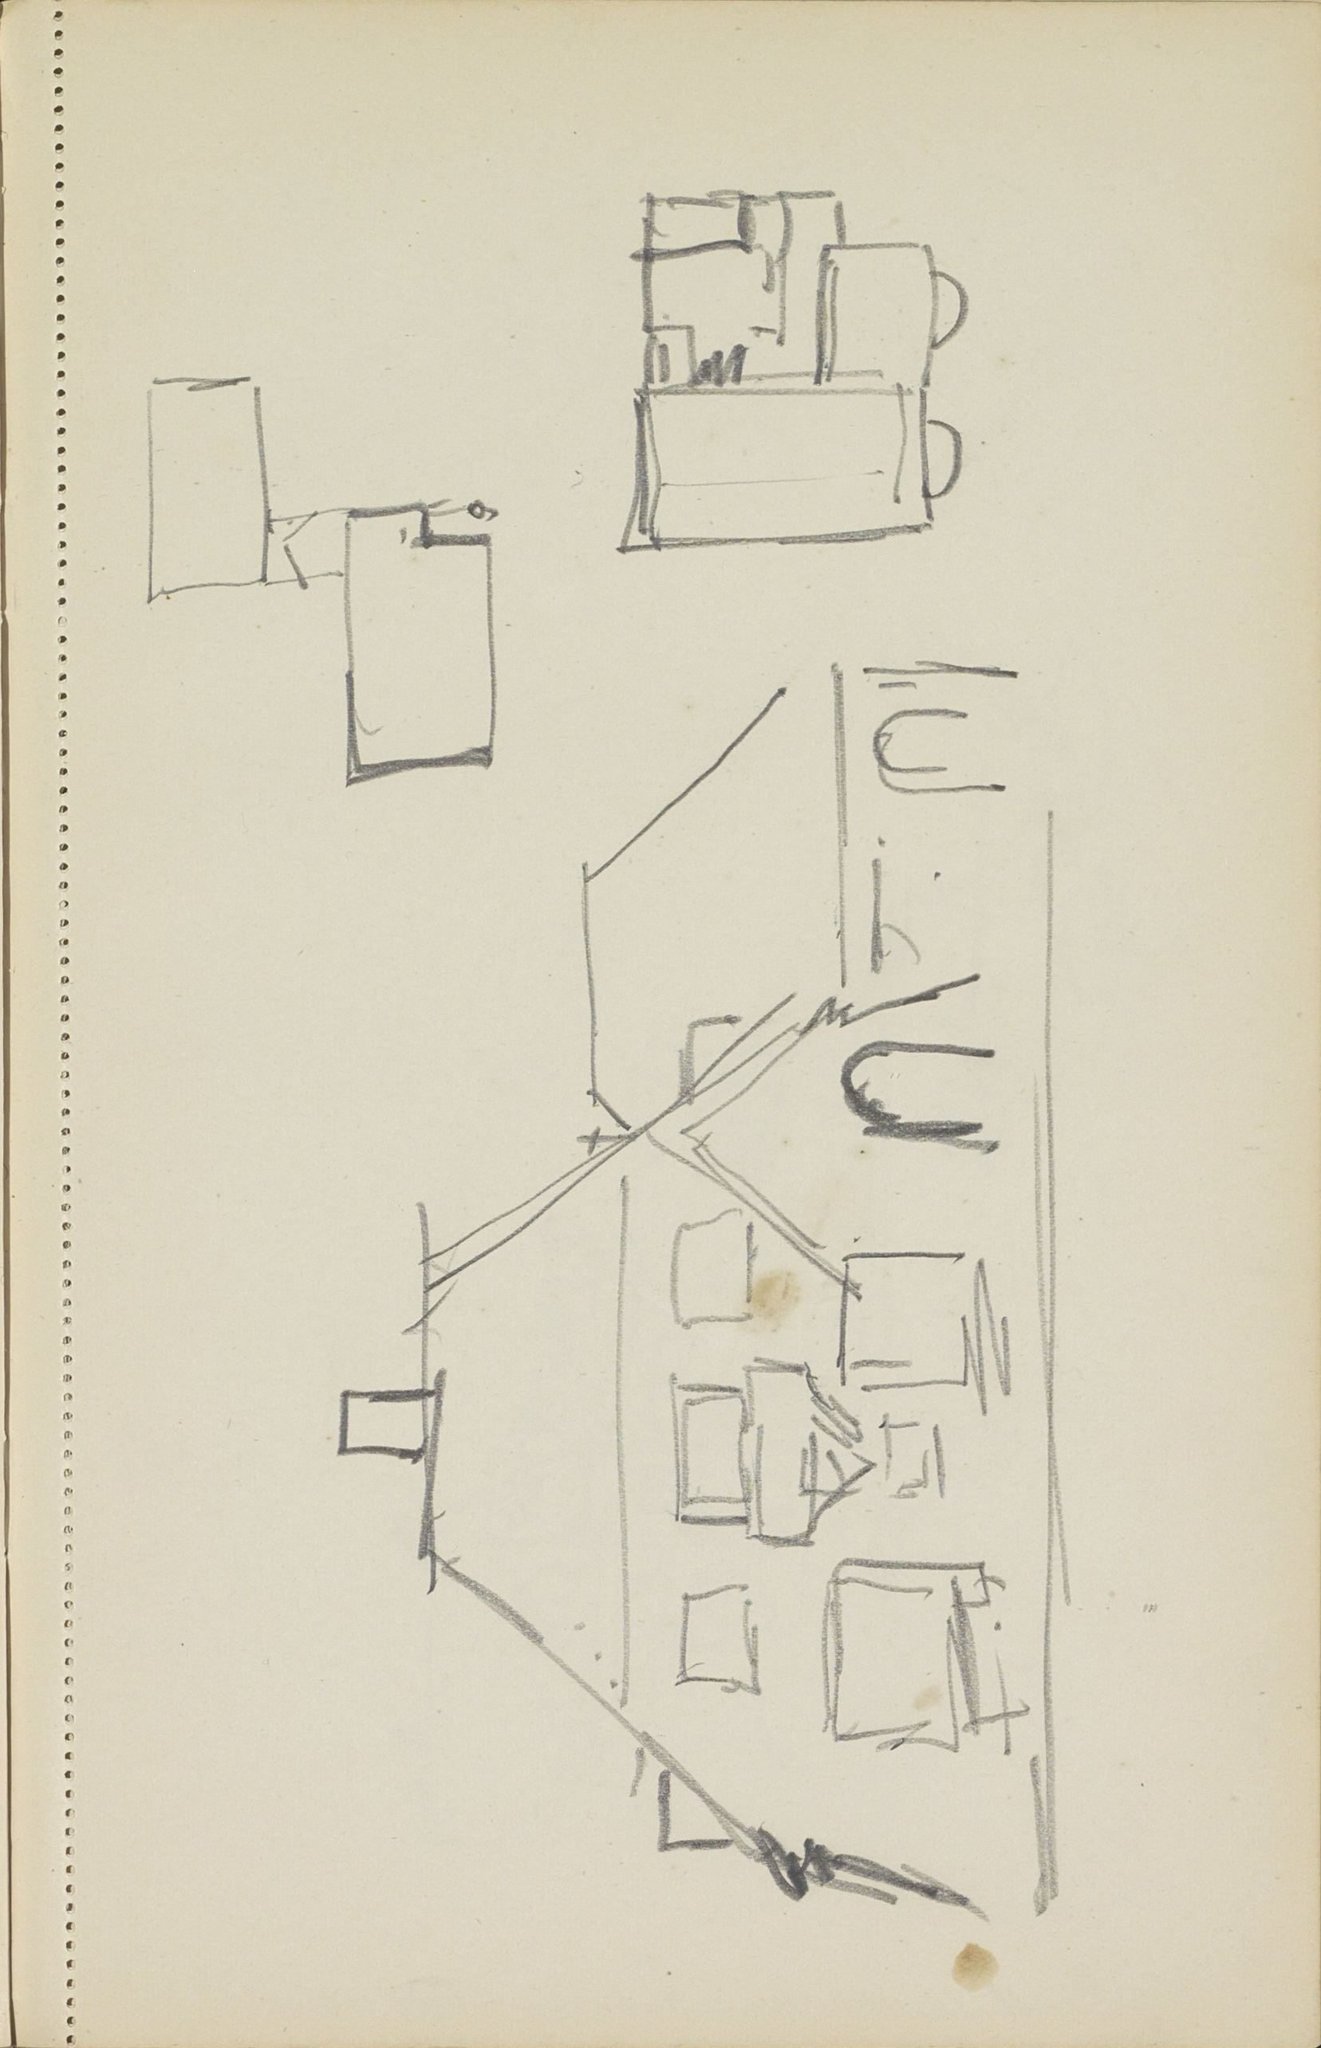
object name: sketchbook leaf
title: Vooraanzicht en plattegrond van een vrijstaand huis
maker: cornelis vreedenburgh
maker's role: draughtsman, print maker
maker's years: 1880-1946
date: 1890-1946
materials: paper, pencil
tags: façade (of house or building), plan ~ architecture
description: Blad 31 recto uit een schetsboek met 56 bladen.